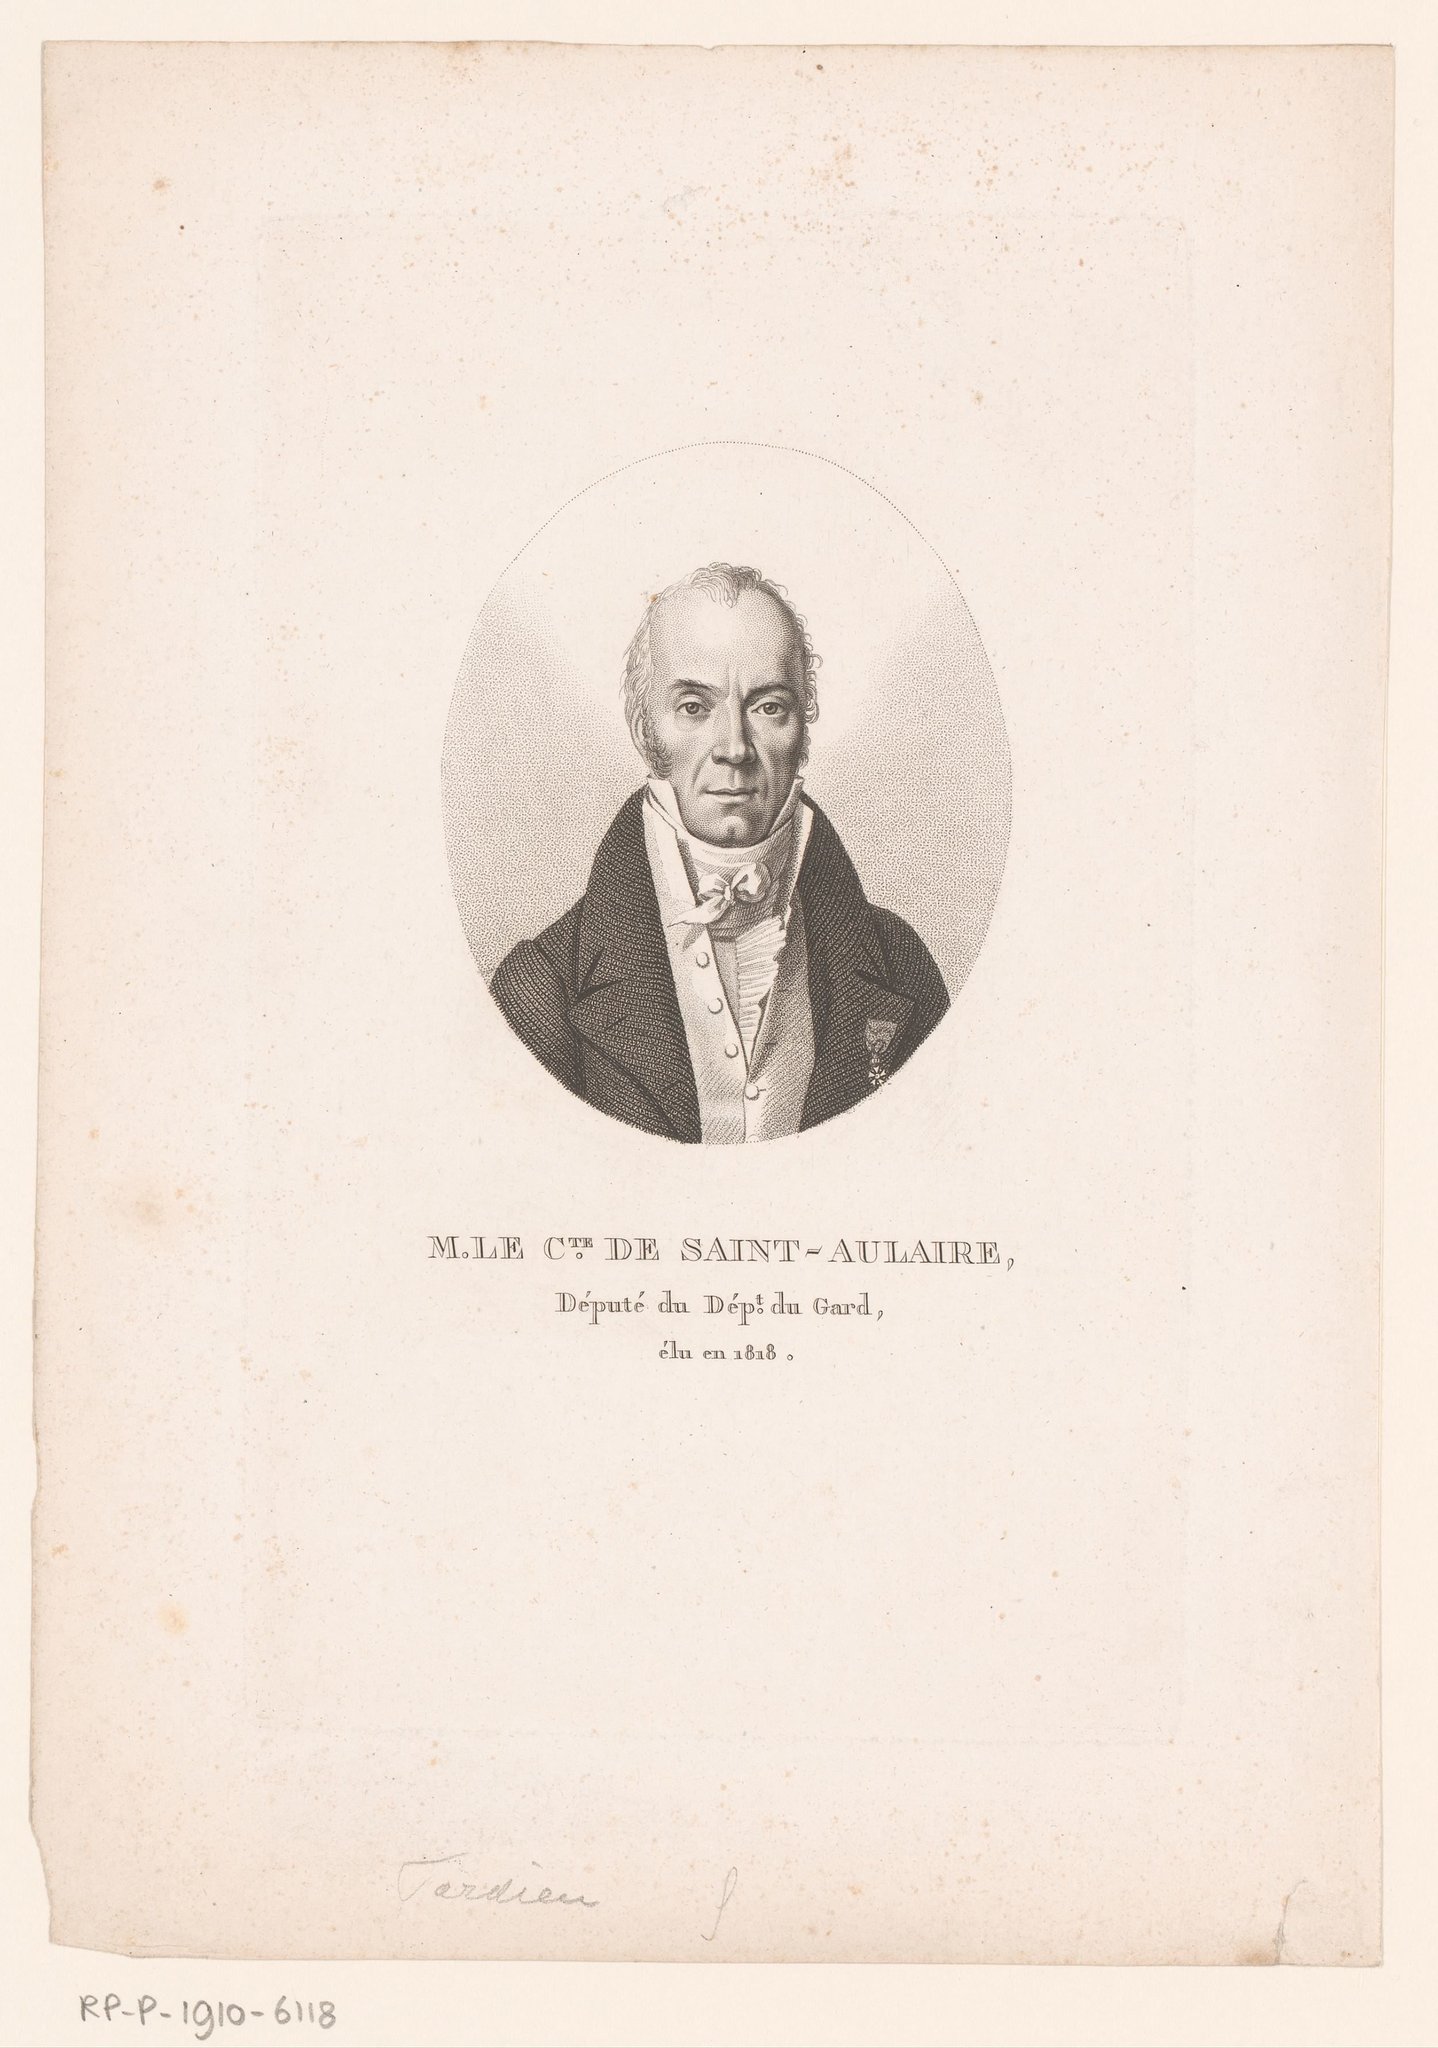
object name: book illustration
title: Portret van Louis de Beaupoil de Saint-Aulaire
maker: ambroise tardieu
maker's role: print maker, printer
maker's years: 1788-1841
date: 1820-1821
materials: paper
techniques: engraving, roulette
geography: paris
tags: paris, politician, historical persons, politician, e.g. party leader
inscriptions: collector's mark: Lugt 2228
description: Prent uit: Tardieu, Ambroise. Portraits des députés, écrivains et pairs constitutionnels, défenseurs invariables de la charte et de la loi des élections du 5 février 1817. Parijs: Tardieu, Ambroise, 1820-1821.